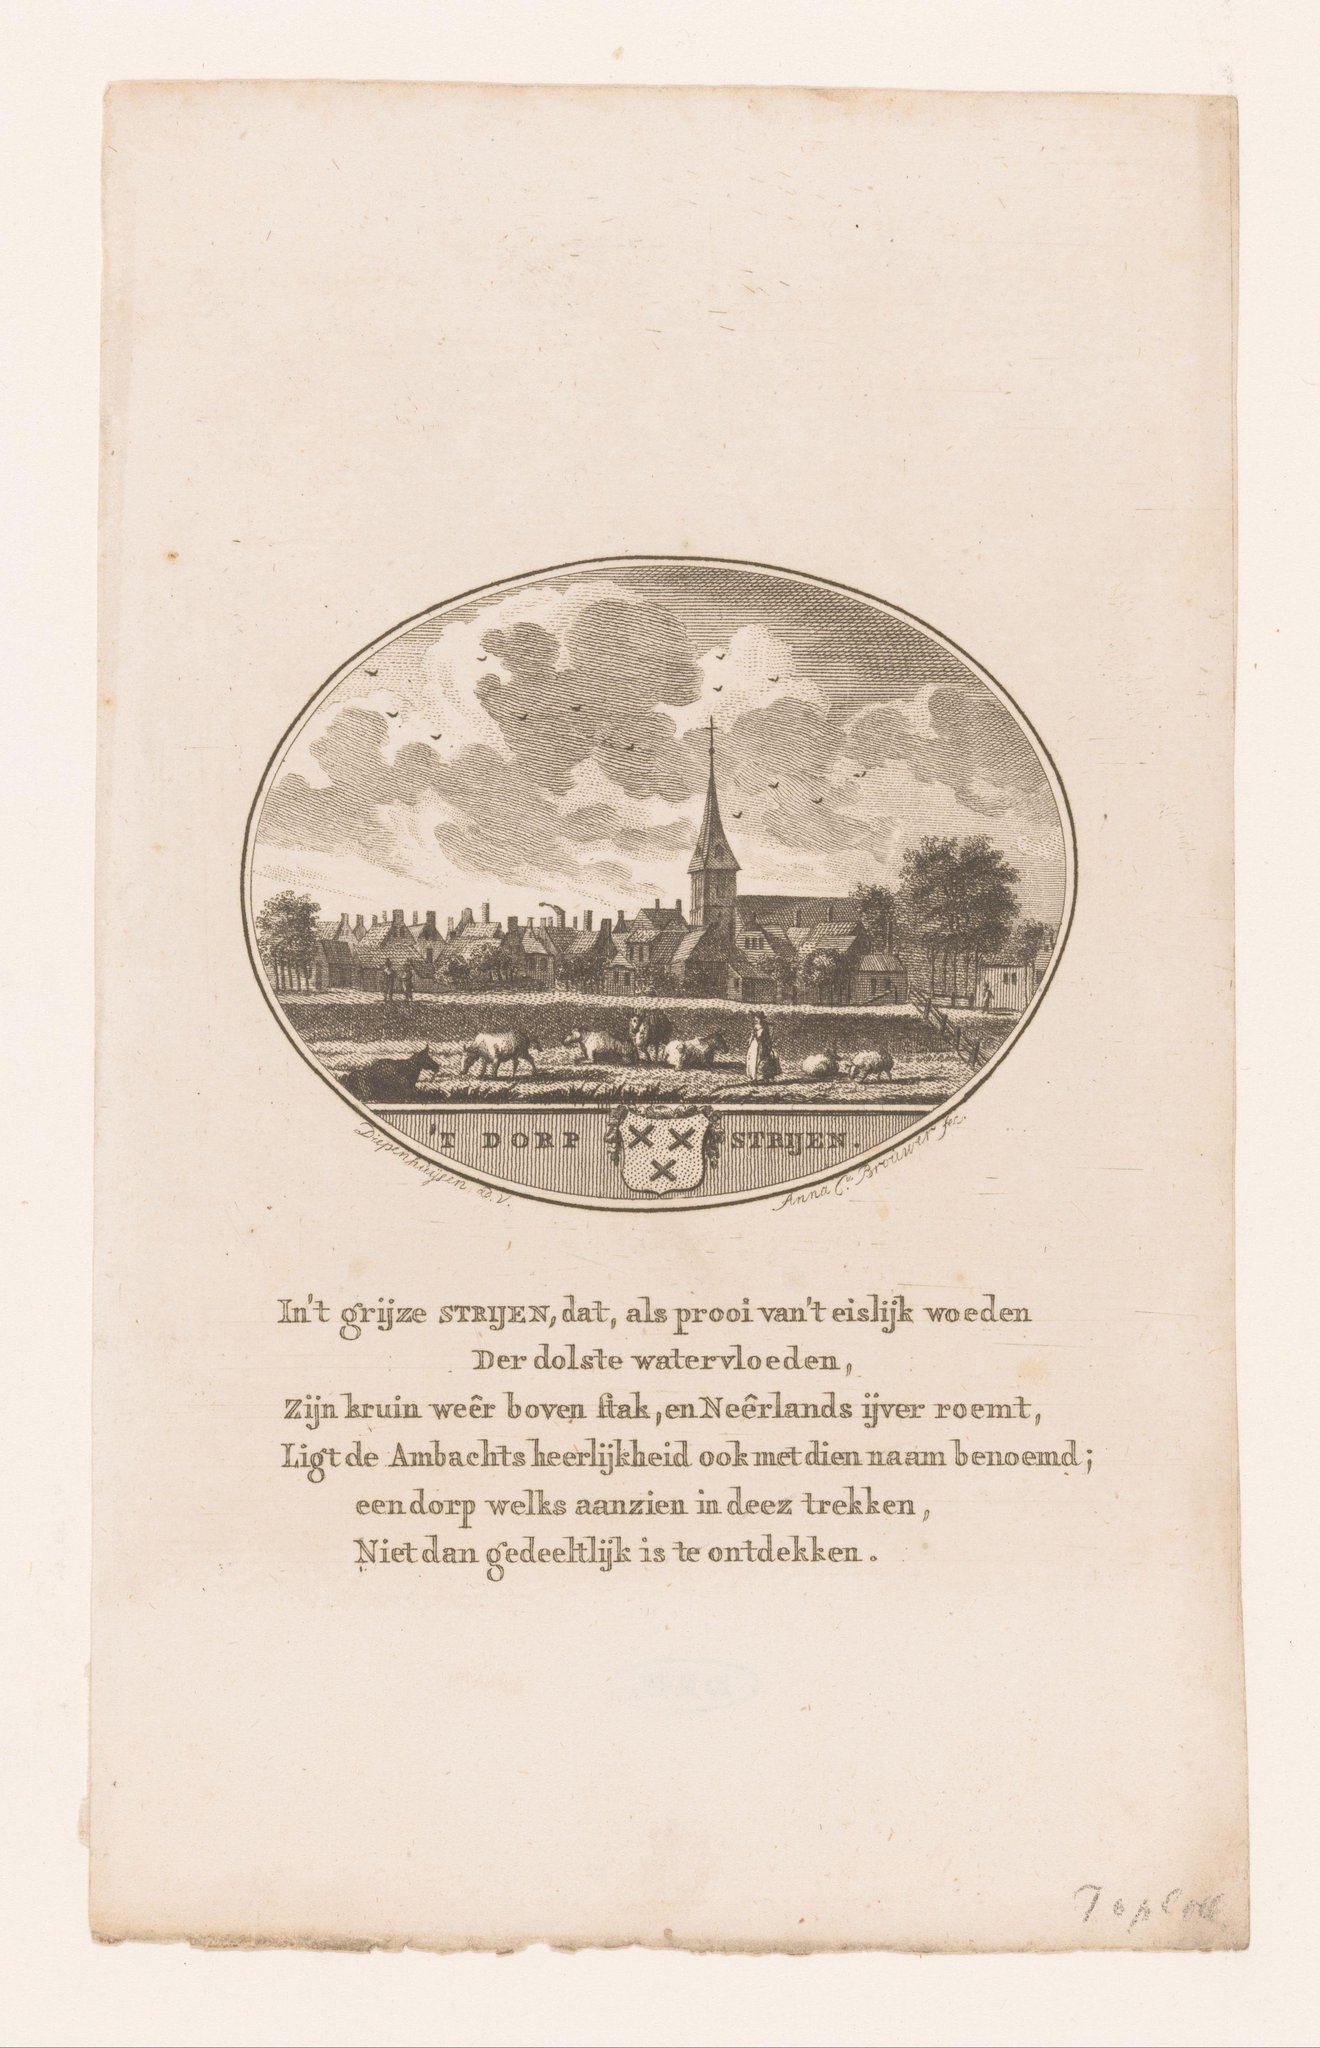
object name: print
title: 'T dorp Strijen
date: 1791-1793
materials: paper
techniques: etching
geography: amsterdam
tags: city-view in general; 'veduta', village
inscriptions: collector's mark: Lugt 2228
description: Prent uit: Ollefen, L. van. De Nederlandsche stad- en dorpbeschrijver. Amsterdam: H.A. Banse, 1793, dl 1.